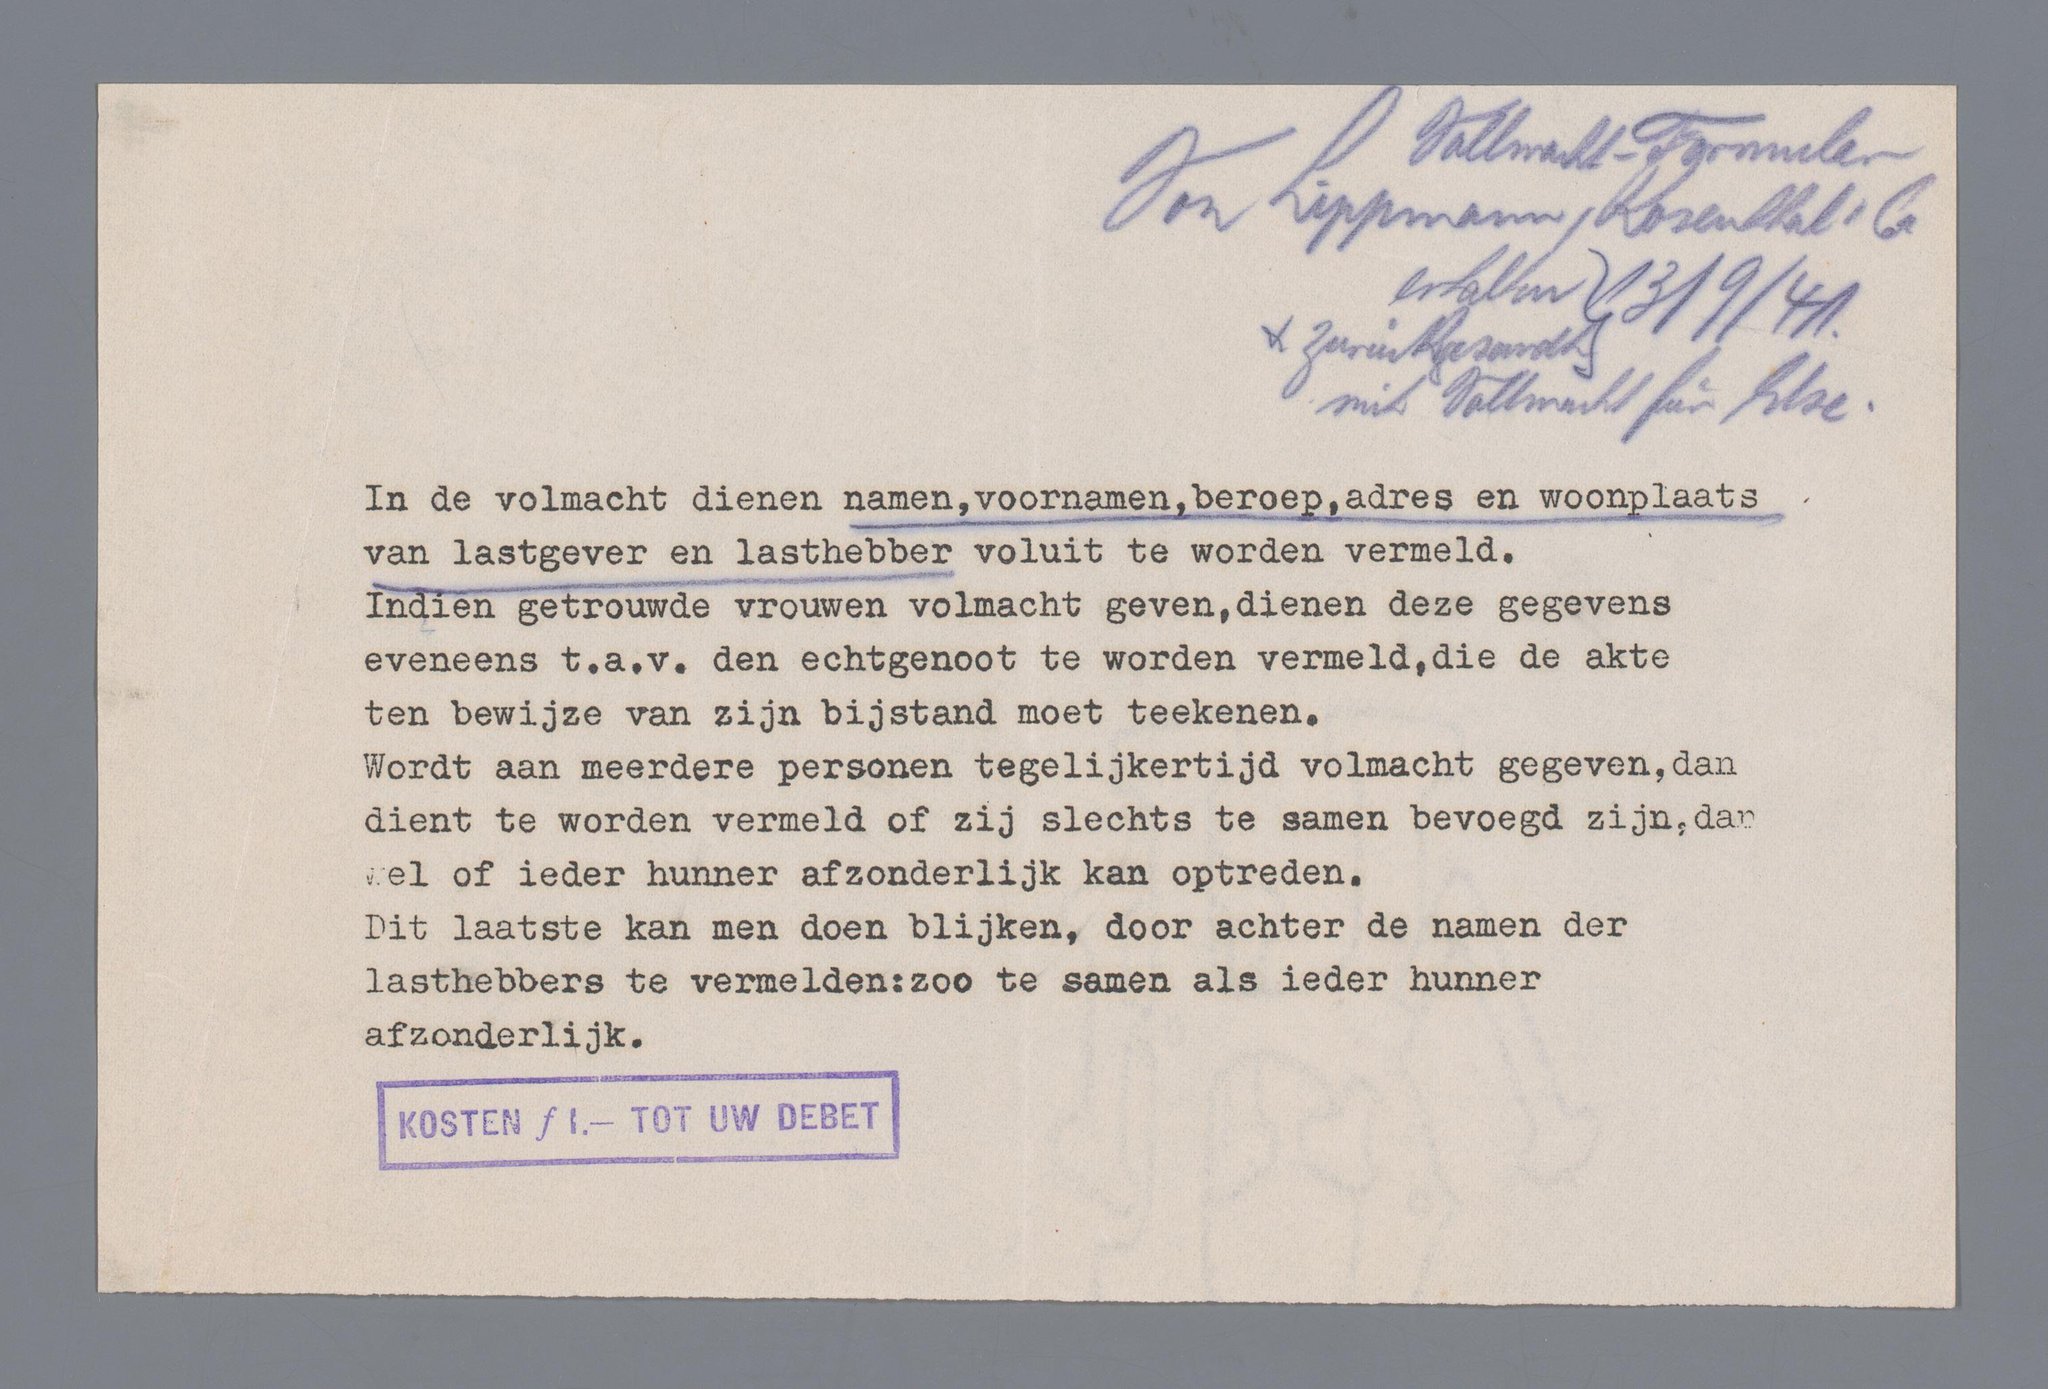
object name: document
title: Volmacht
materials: paper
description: Dit object is onderdeel van de nalatenschap van Isabel Elon-Wachenheimer (1928-2010). Tot haar overlijden behoorde het samen met de andere objecten uit de nalatenschap tot haar privédomein van Isabel Wachenheimer. In die particuliere context zijn deze objecten tezamen en individueel aandenkens - aan de jeugd, ouders en familie van Isabel Wachenheimer vóór en tijdens de Shoah en aan haar leven na de Tweede Wereldoorlog. Isabel Wachenheimer, die van juni 1943 tot mei 1945 gevangen zat in Kamp Westerbork, Theresienstadt, Auschwitz, Lenzing a/d Oberdonau (een buitenkamp van Mauthausen), overleefde de Shoah. Haar ouders – Eugène Wachenheimer en Else Wachenheimer-Moos - werden op 14 oktober 1944 in Auschwitz-Birkenau vermoord.